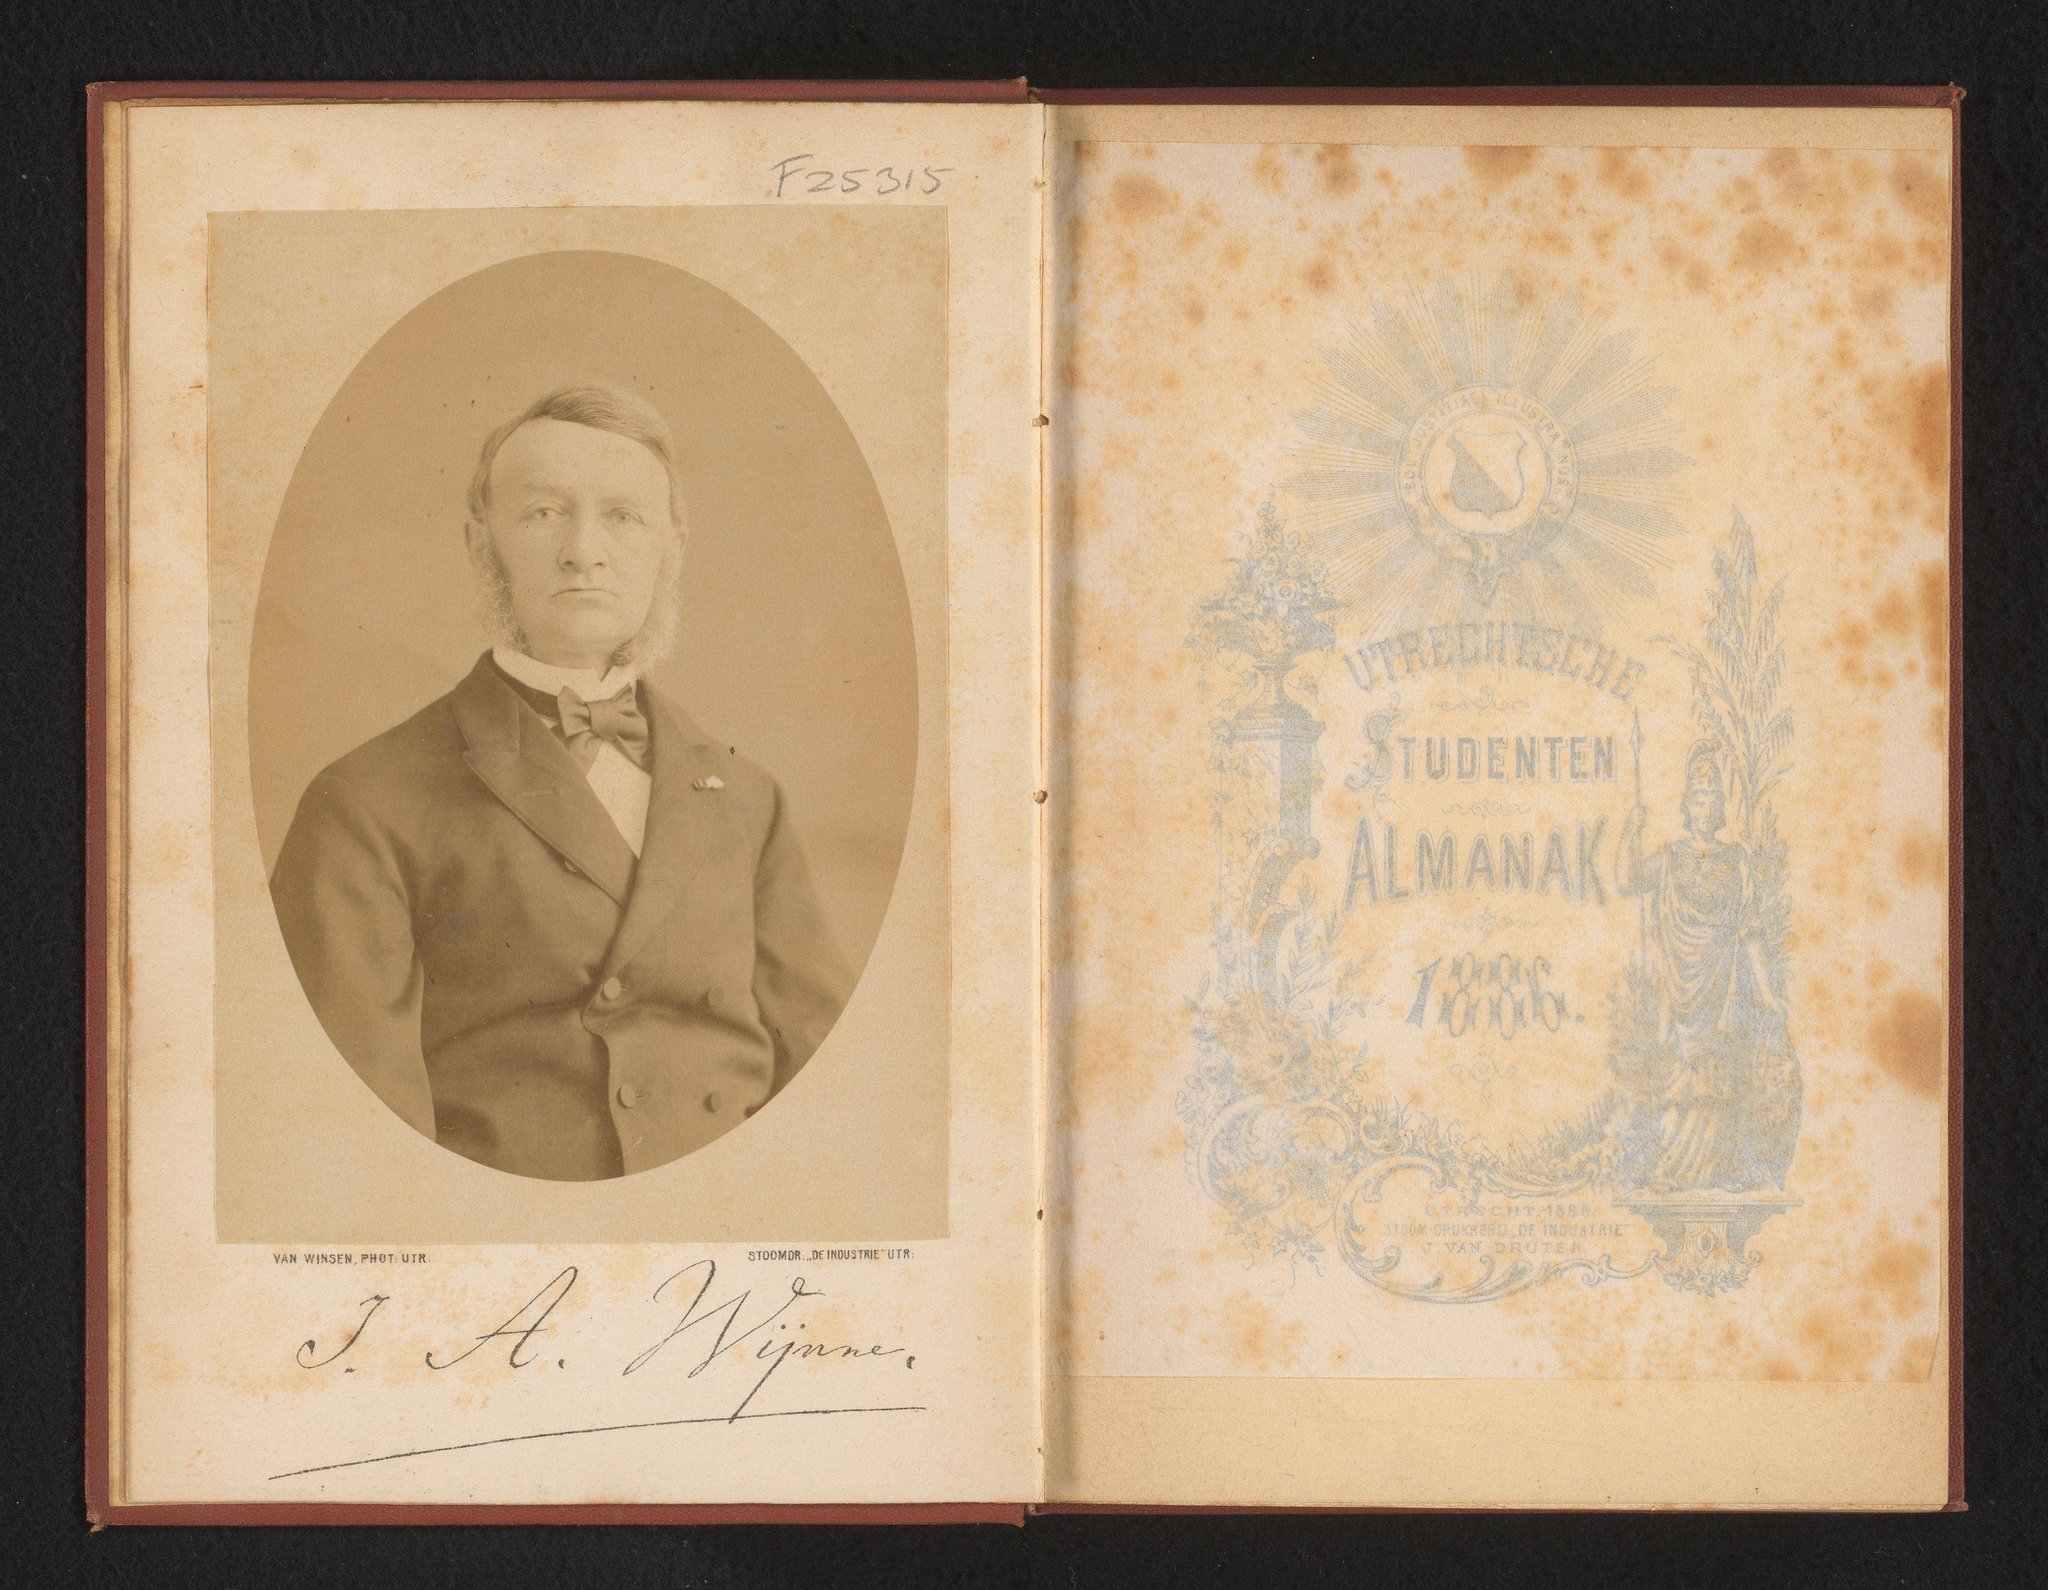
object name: photograph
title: Portret van J.A. Wijnne, hoogleraar letteren en wijsbegeerte en rector magnificus van de Universiteit Utrecht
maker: jean jacques antoine van winsen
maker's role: fotograaf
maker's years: 1851-1927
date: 1885-1886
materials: paper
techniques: albumen print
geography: utrecht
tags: utrecht, historical persons, professor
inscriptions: signature: ‘J.A. Wijnne’